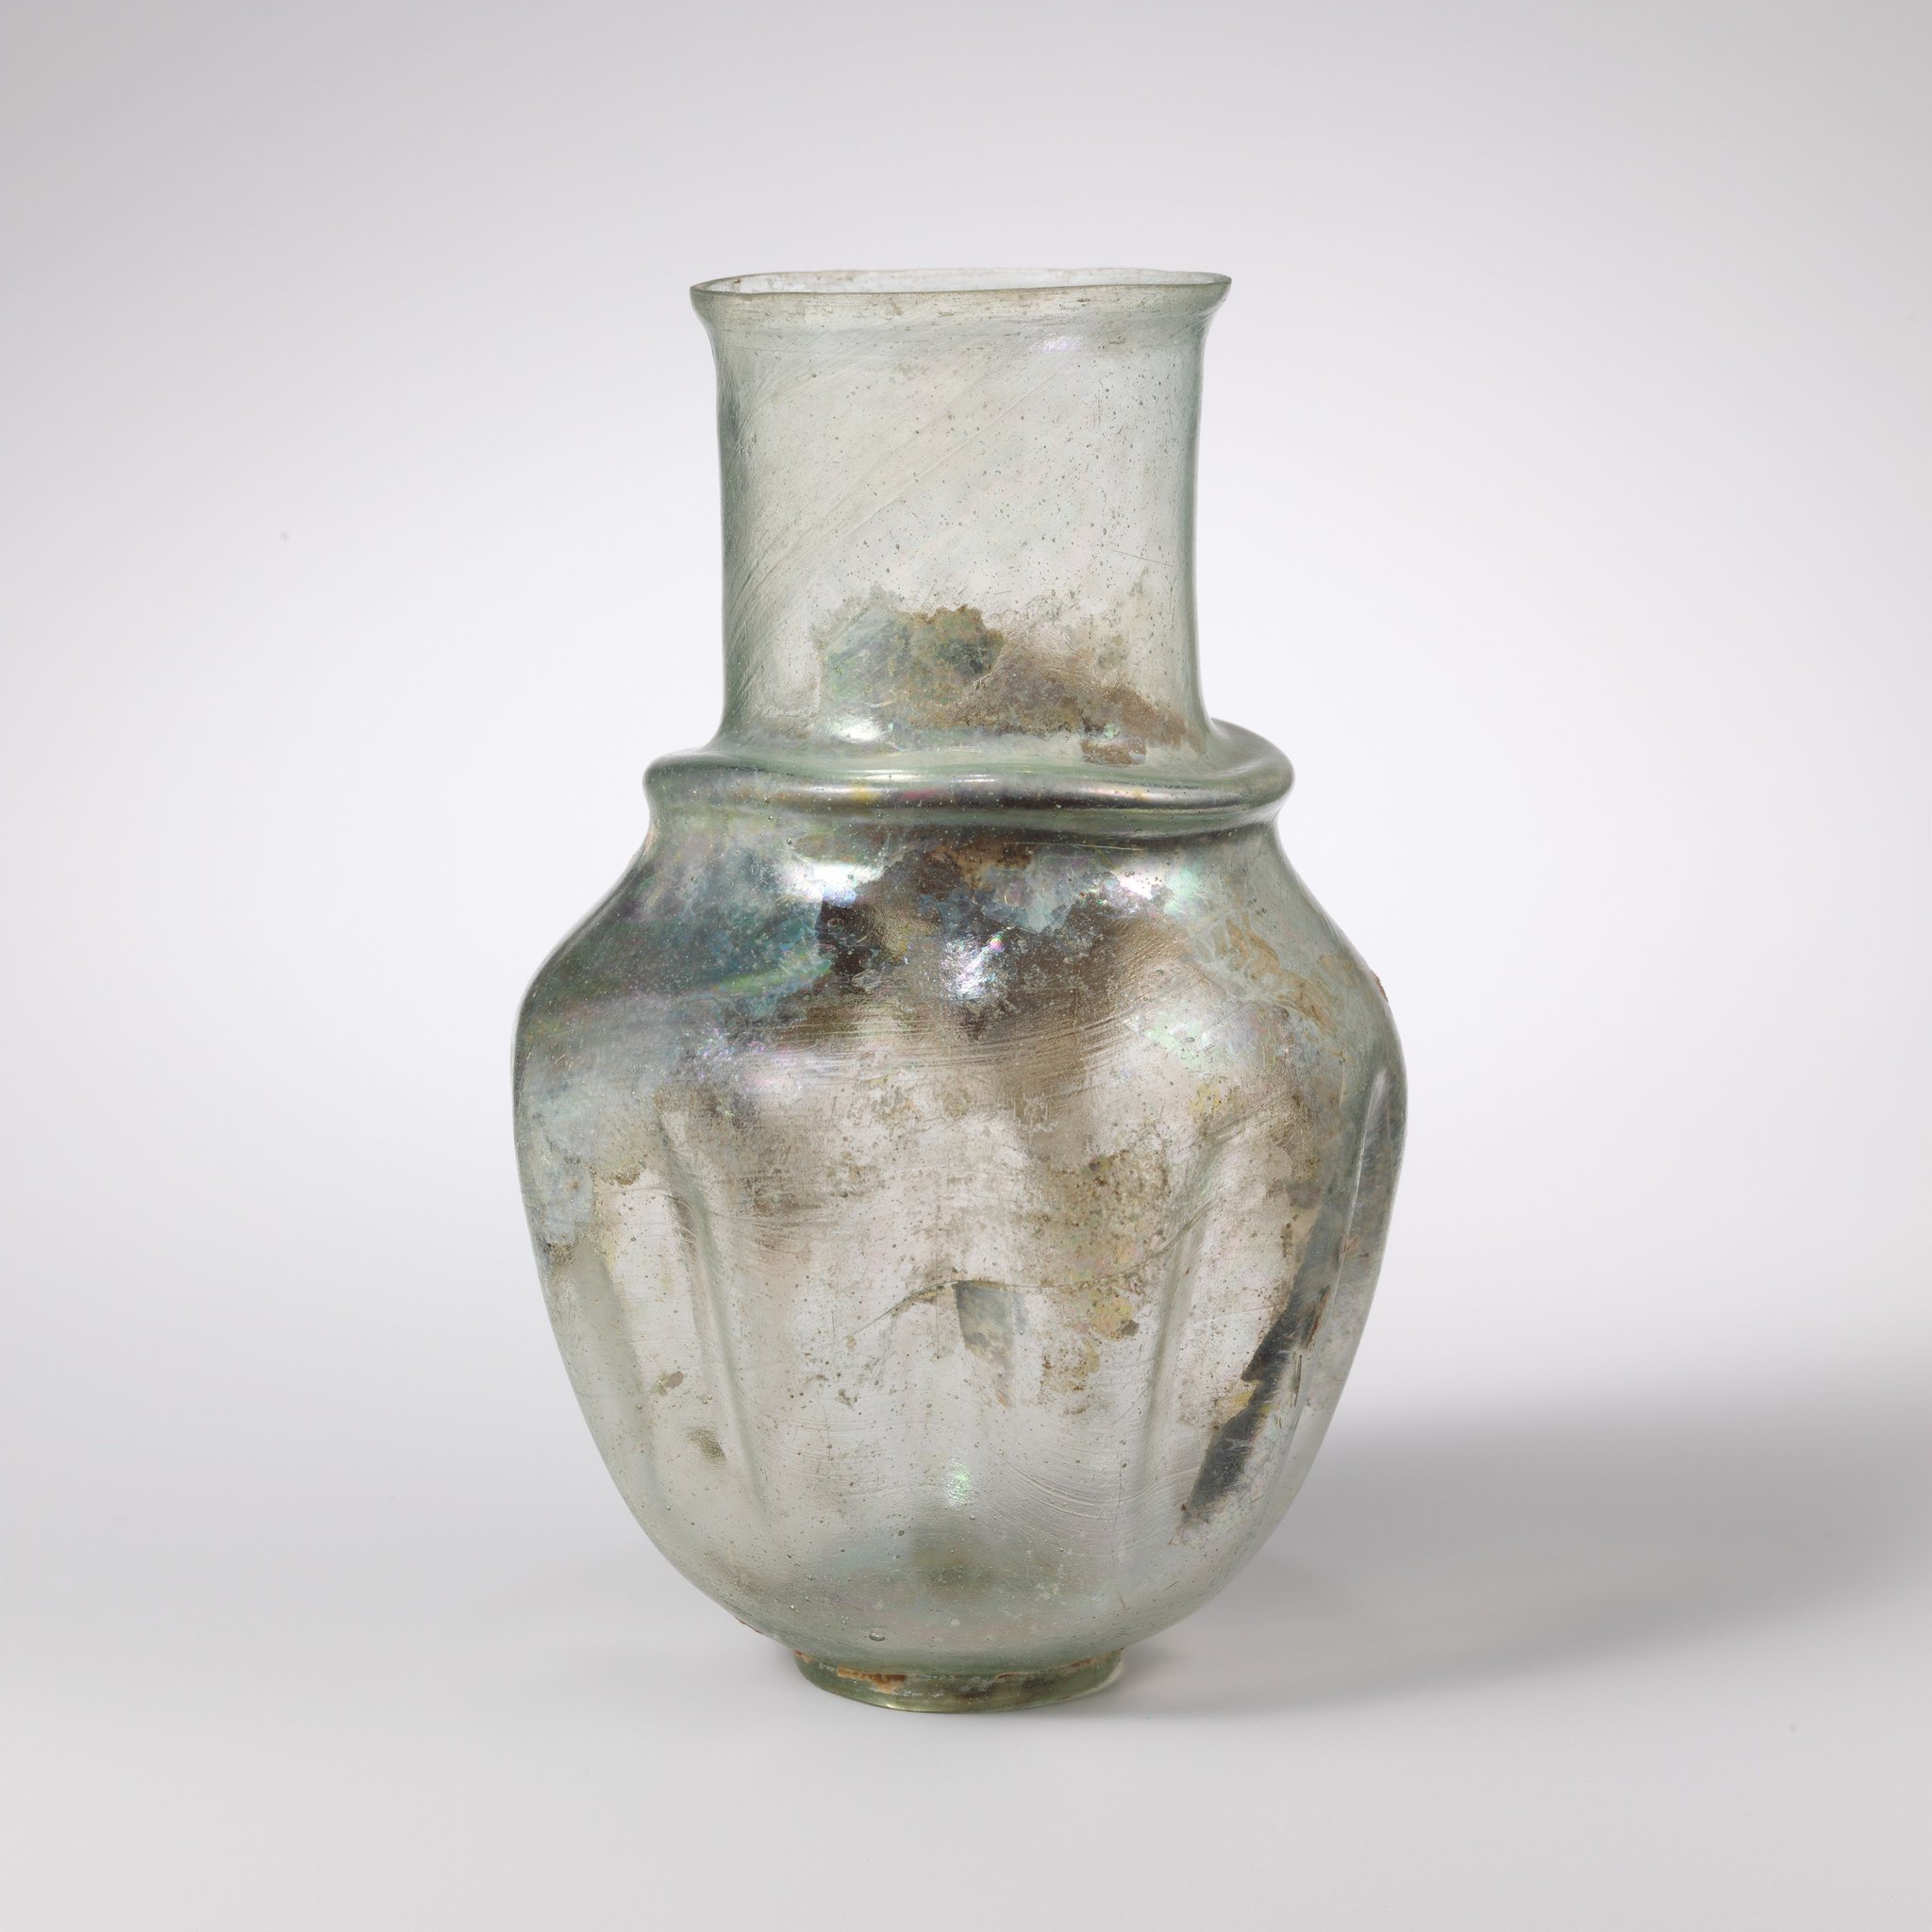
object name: jar, indented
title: Glass indented jar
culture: roman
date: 101-400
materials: glass